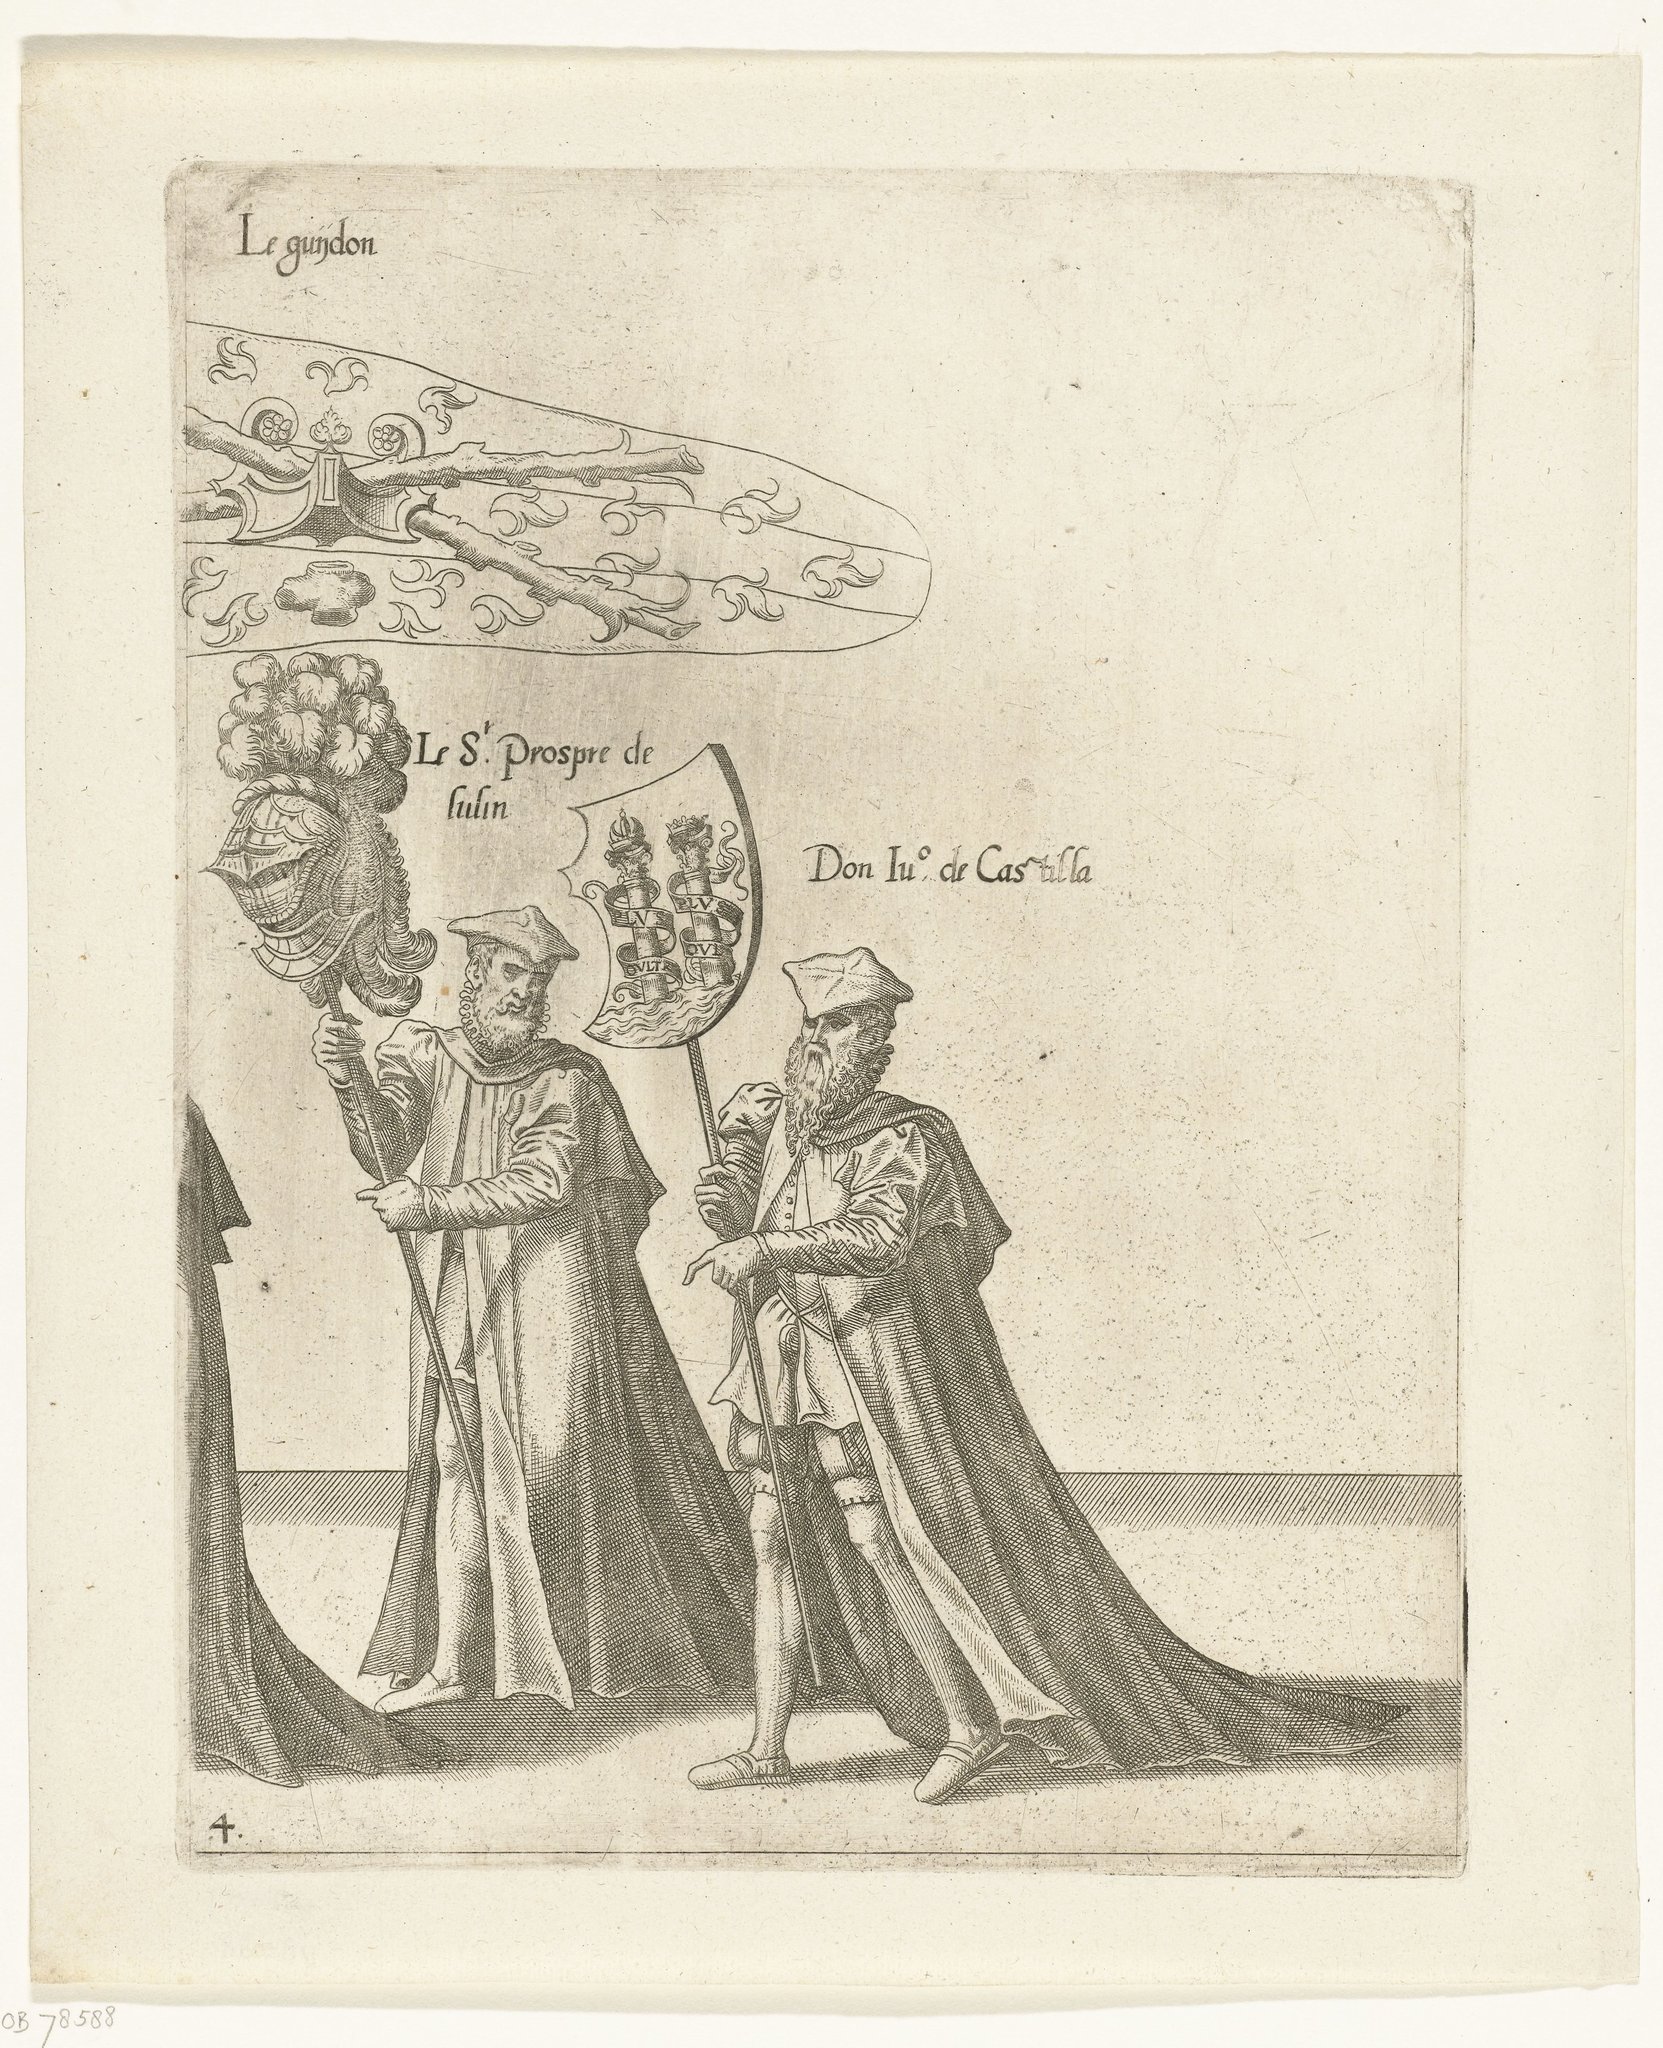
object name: print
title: Begrafenisoptocht van keizer Karel V, 1558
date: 1559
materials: paper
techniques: engraving, etching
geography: southern netherlands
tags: ghent, charles v (holy roman emperor and king of spain), cortege, funeral procession, brussels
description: Twee deelnemers aan de optocht met helm en embleem op standaarden. Onderdeel van de prentreeks van de Begrafenisoptocht van keizer Karel V op 29 december 1558 te Brussel.